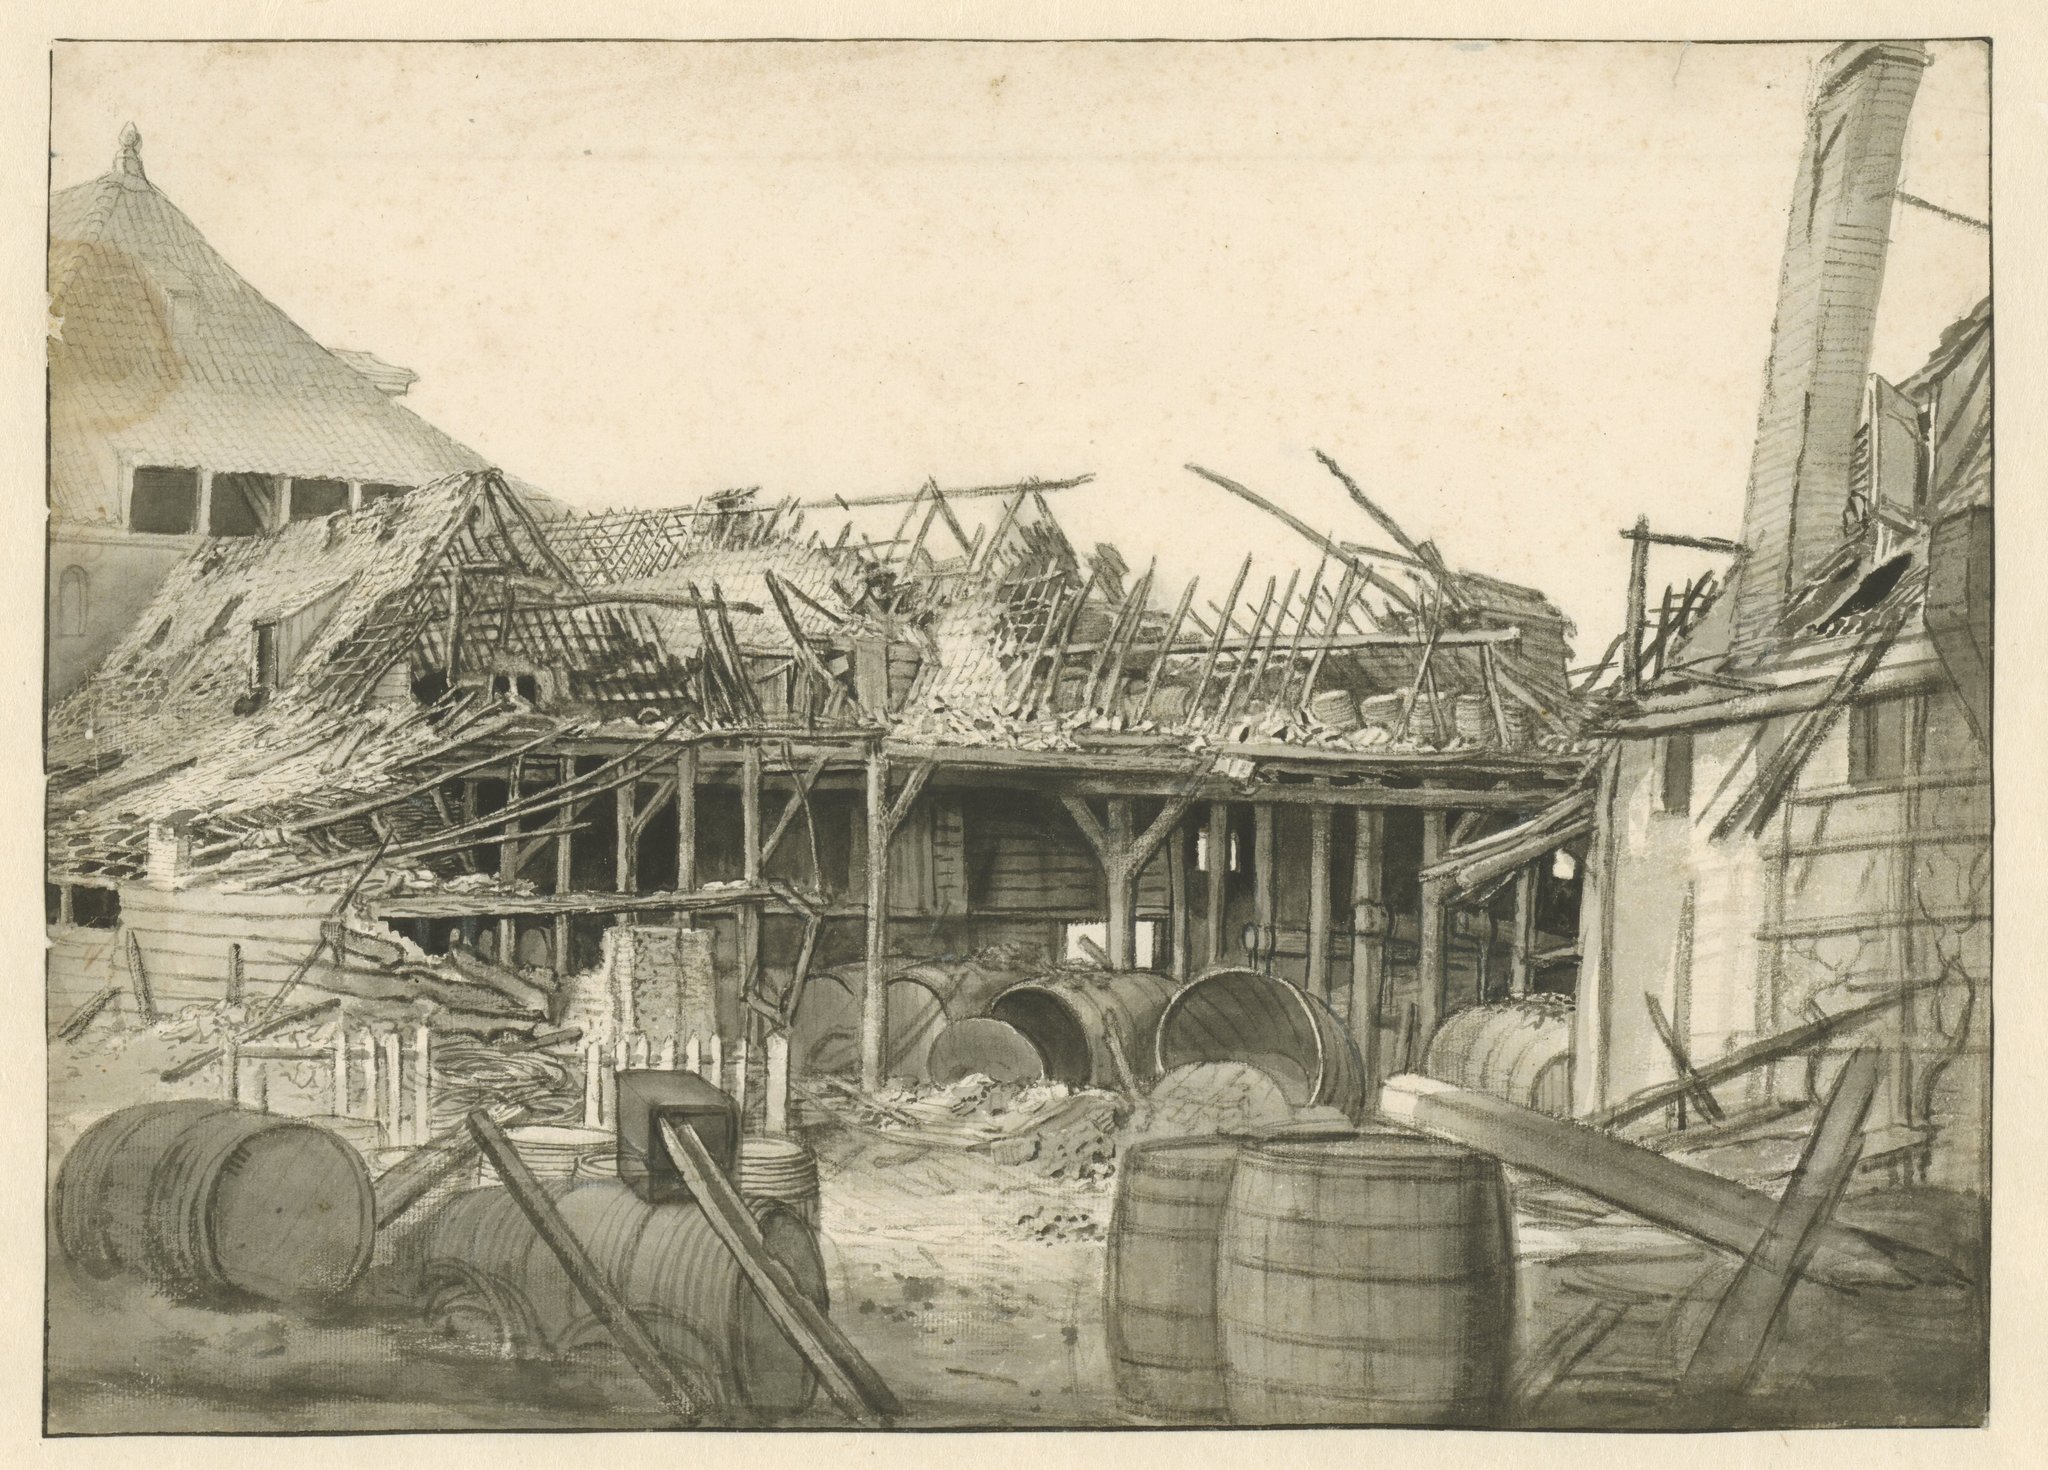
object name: drawing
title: Overblijfselen van een uitgebrand pakhuis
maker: jan van der heyden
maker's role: draughtsman, painter, print maker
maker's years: 1637-1712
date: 1680-1690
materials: chalk, ink, paper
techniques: brush, pen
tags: ruin of a building ~ architecture, deposits of combustion, the usual house or row of houses